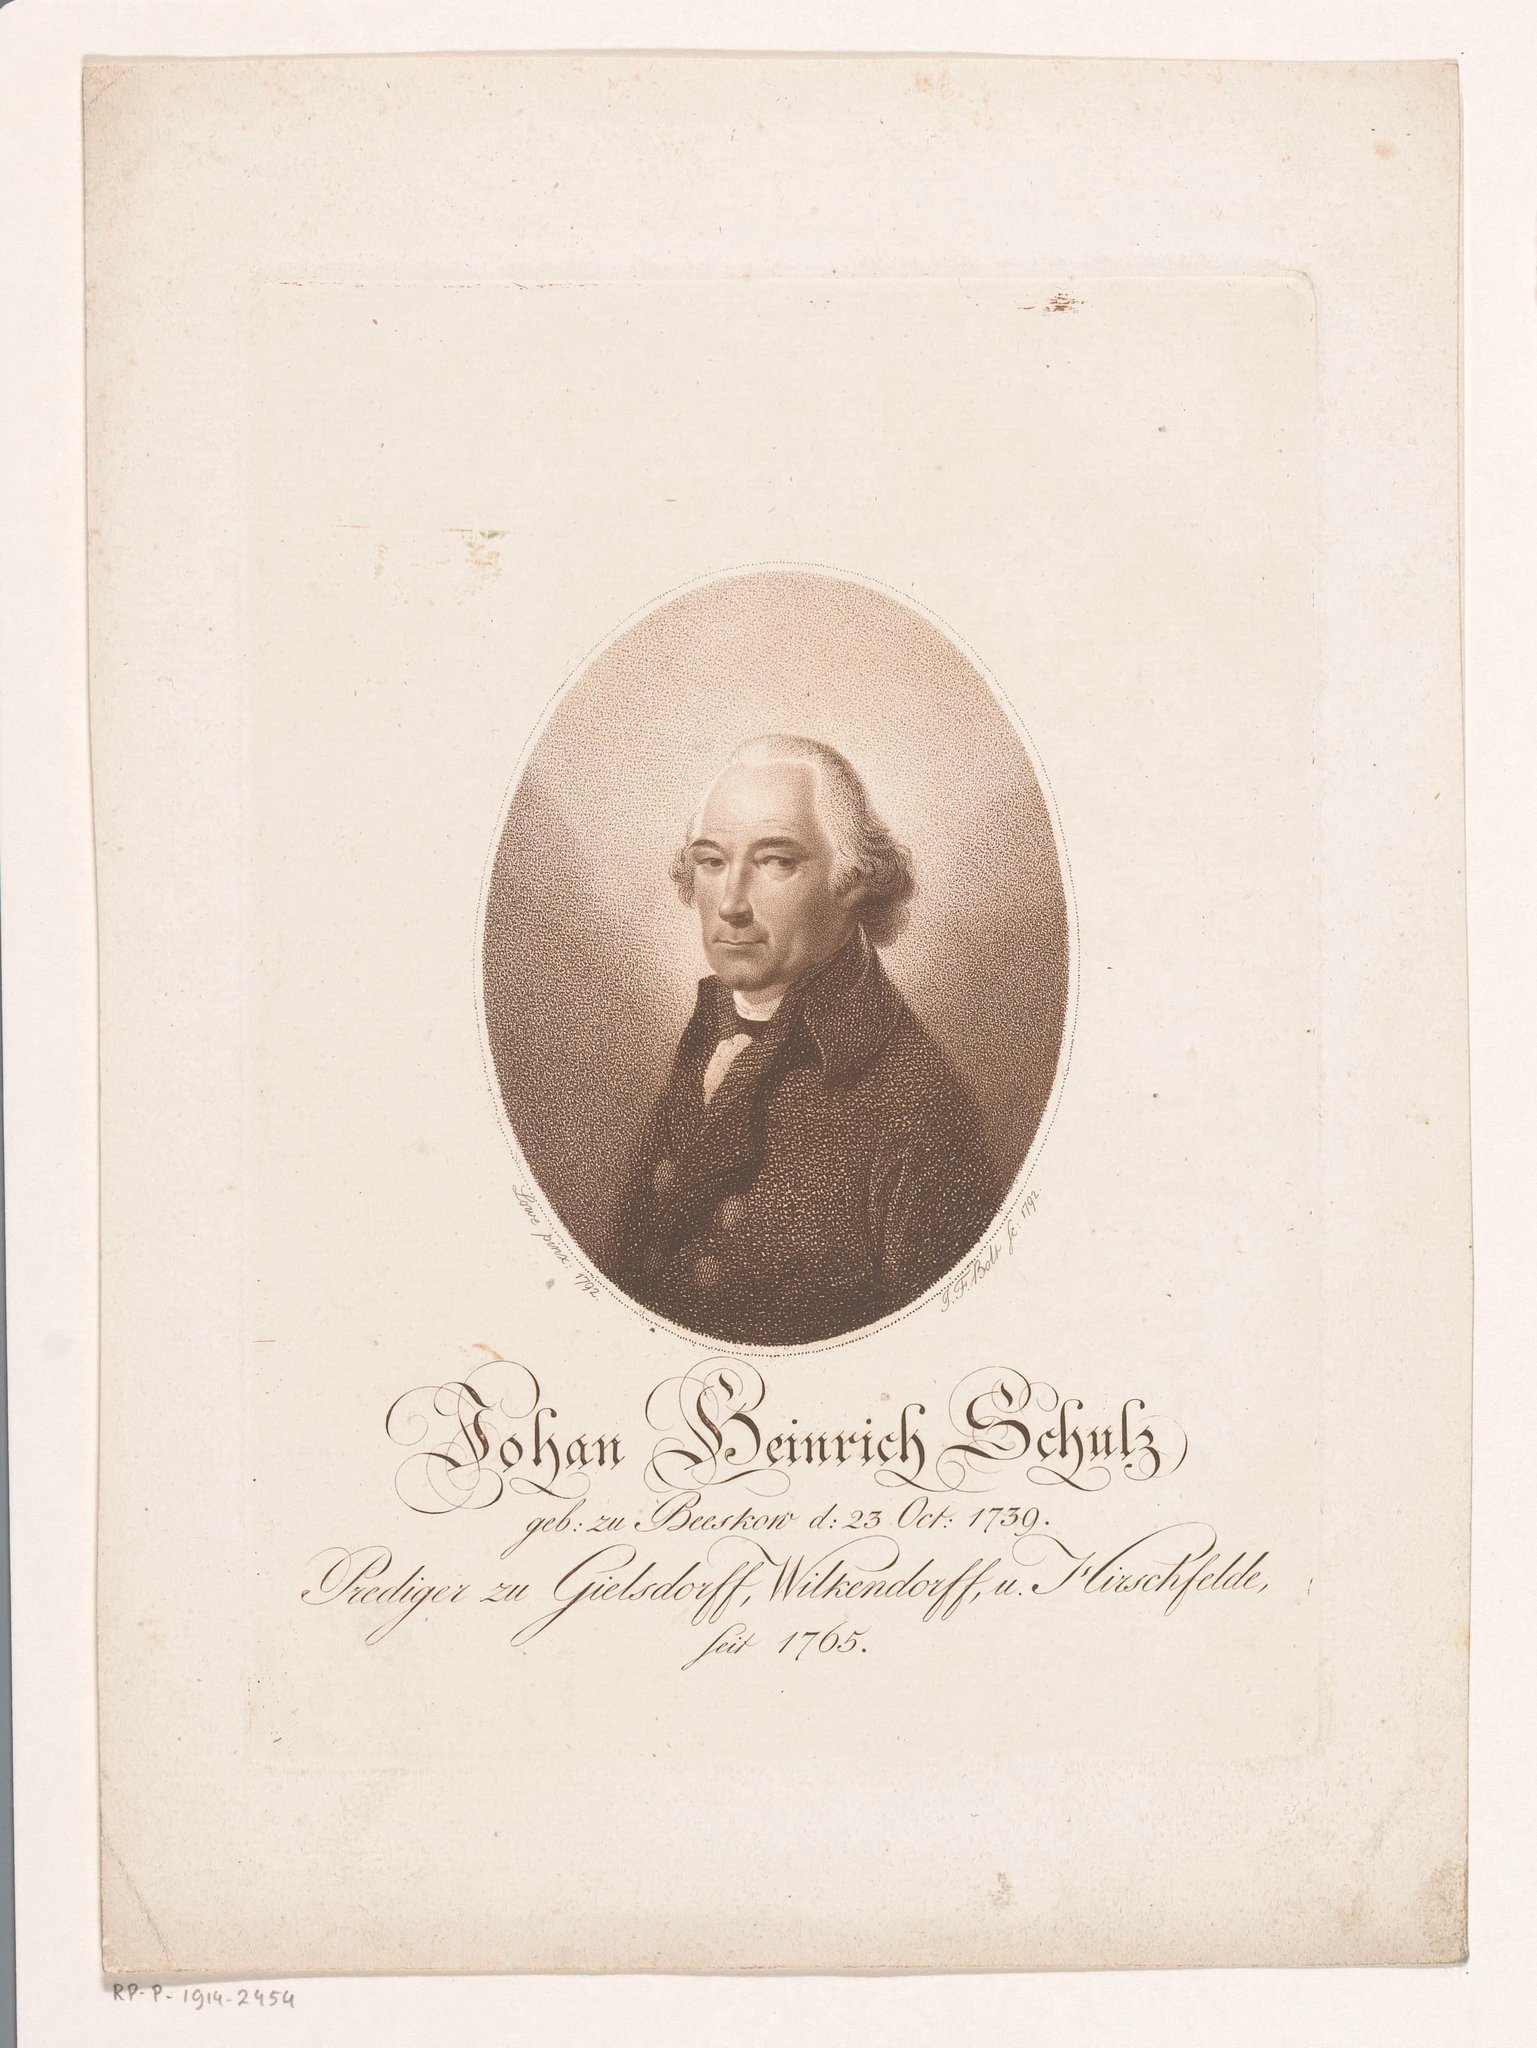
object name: print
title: Portret van Johann Heinrich Schulz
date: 1792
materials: paper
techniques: stippling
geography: berlin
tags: historical persons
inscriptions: collector's mark: Lugt 2228